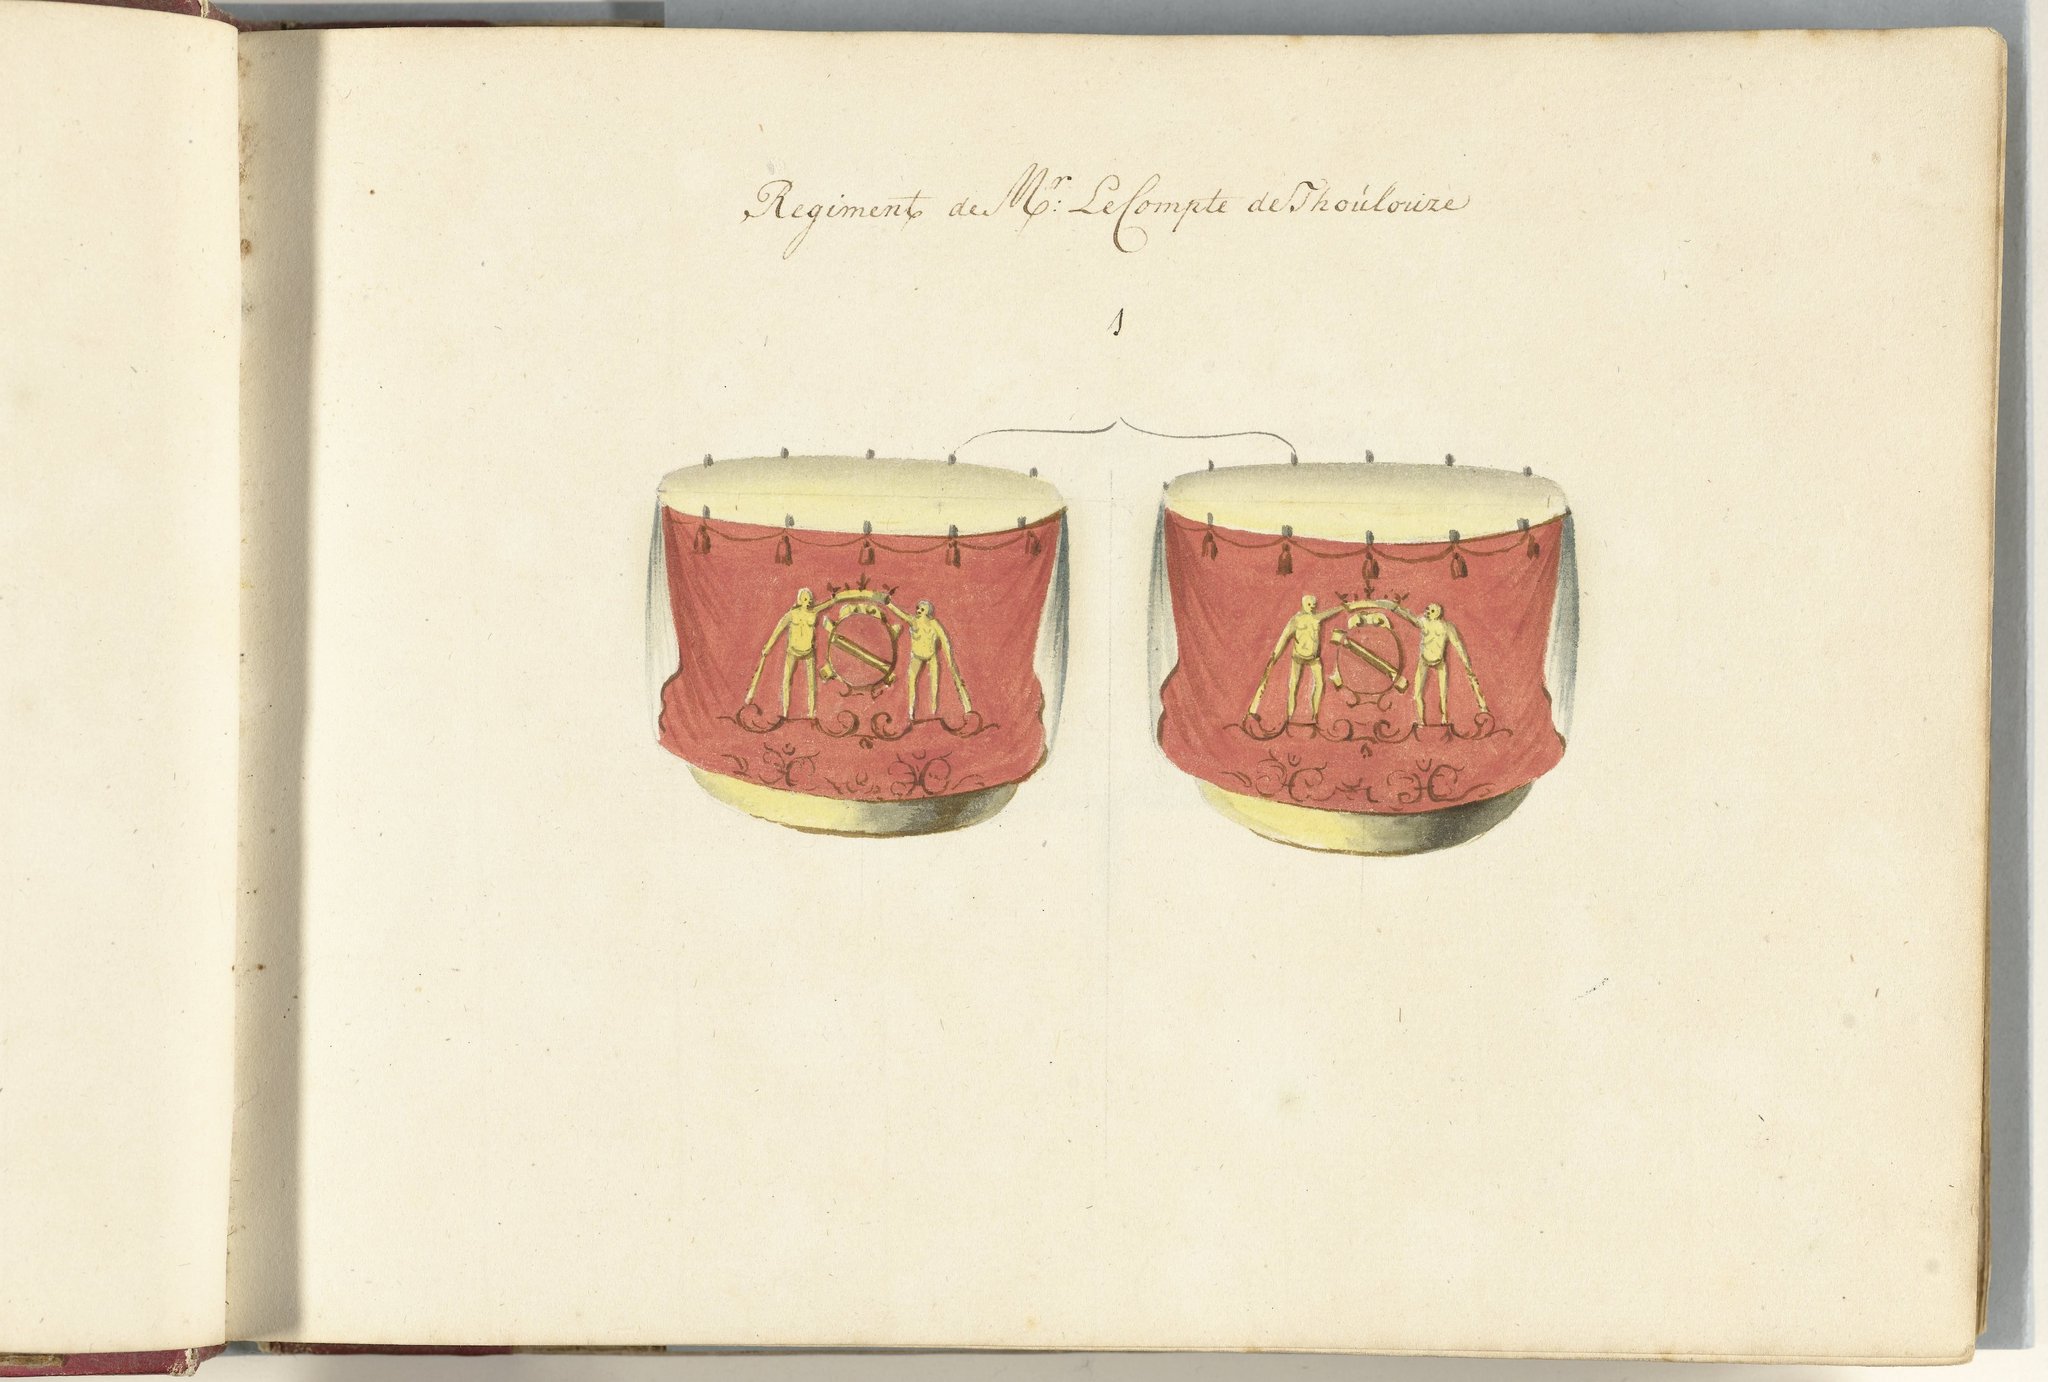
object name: drawing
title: Regiment de Mr. LeCompte de Thoulouze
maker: Anonymous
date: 1713-1720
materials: paper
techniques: drawing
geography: northern netherlands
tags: military music, drum (musical instrument)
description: Franse pauken veroverd in de slag bij Spierbach, 1703. In het boek met tekeningen van Franse vaandels, standaarden en pauken, veroverd tijdens de Spaanse Successieoorlog (1701-1713).